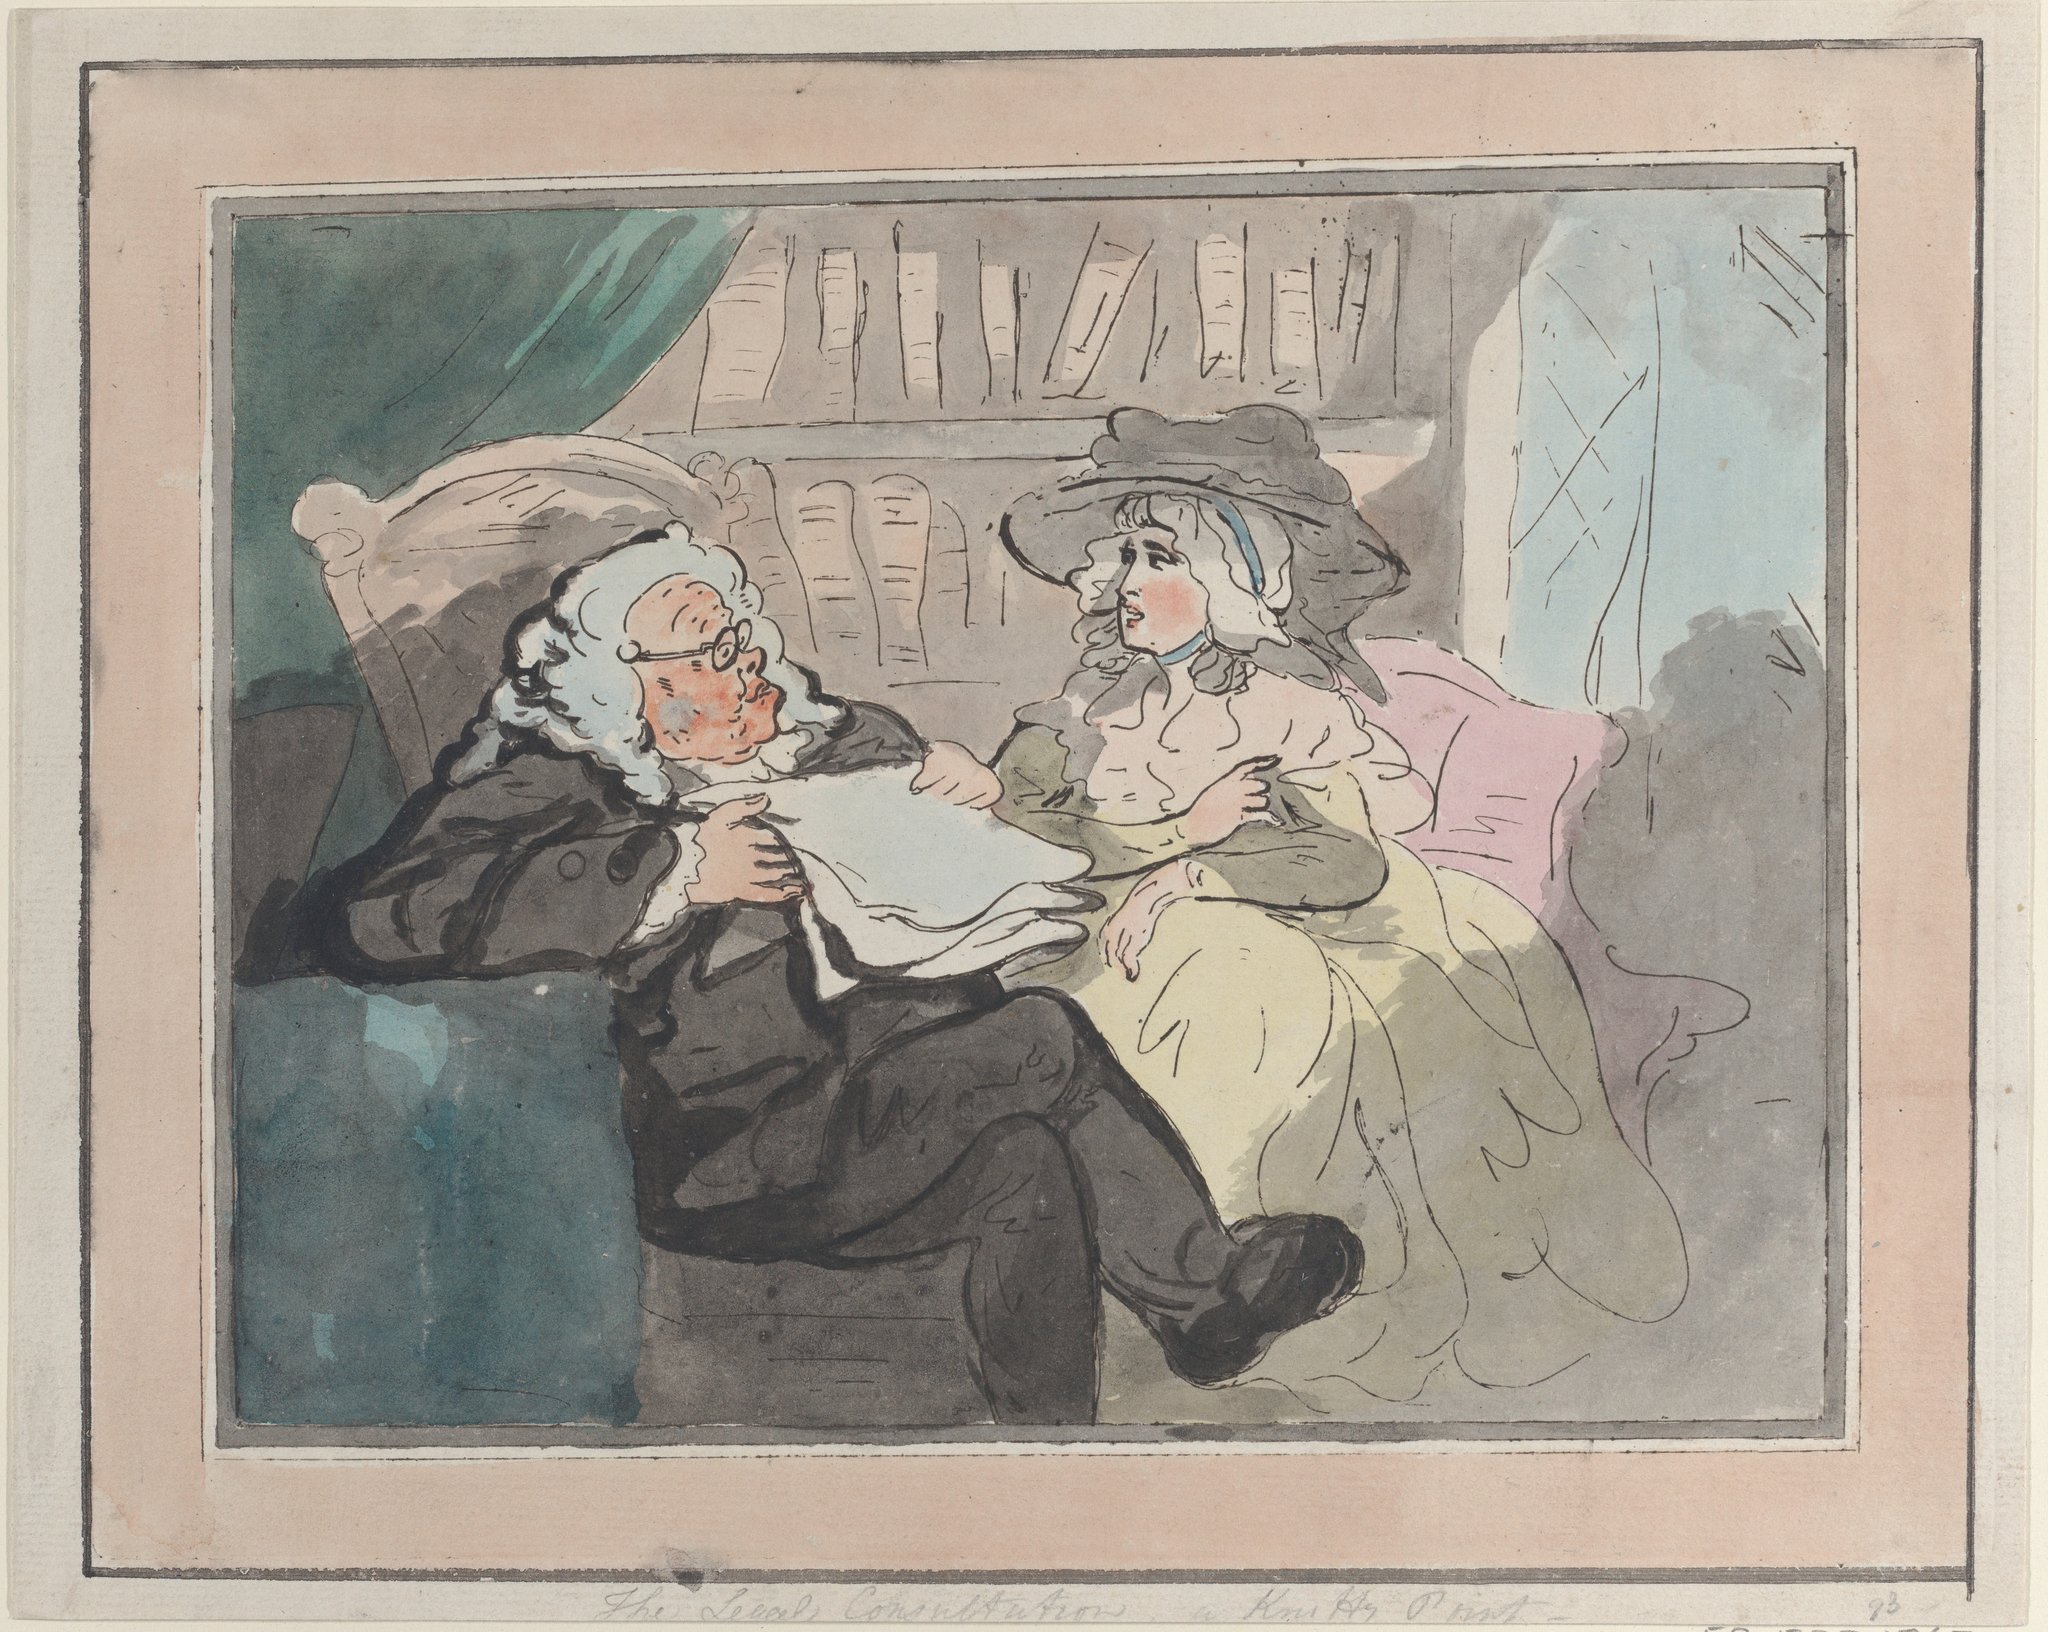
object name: print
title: A Counselor's Opinion After He Had Retired From Practice – The Legal Consultation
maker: thomas rowlandson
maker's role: artist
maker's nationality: british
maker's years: 1757-1827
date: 1780-1794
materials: ink, watercolor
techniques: pen, wash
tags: men,women